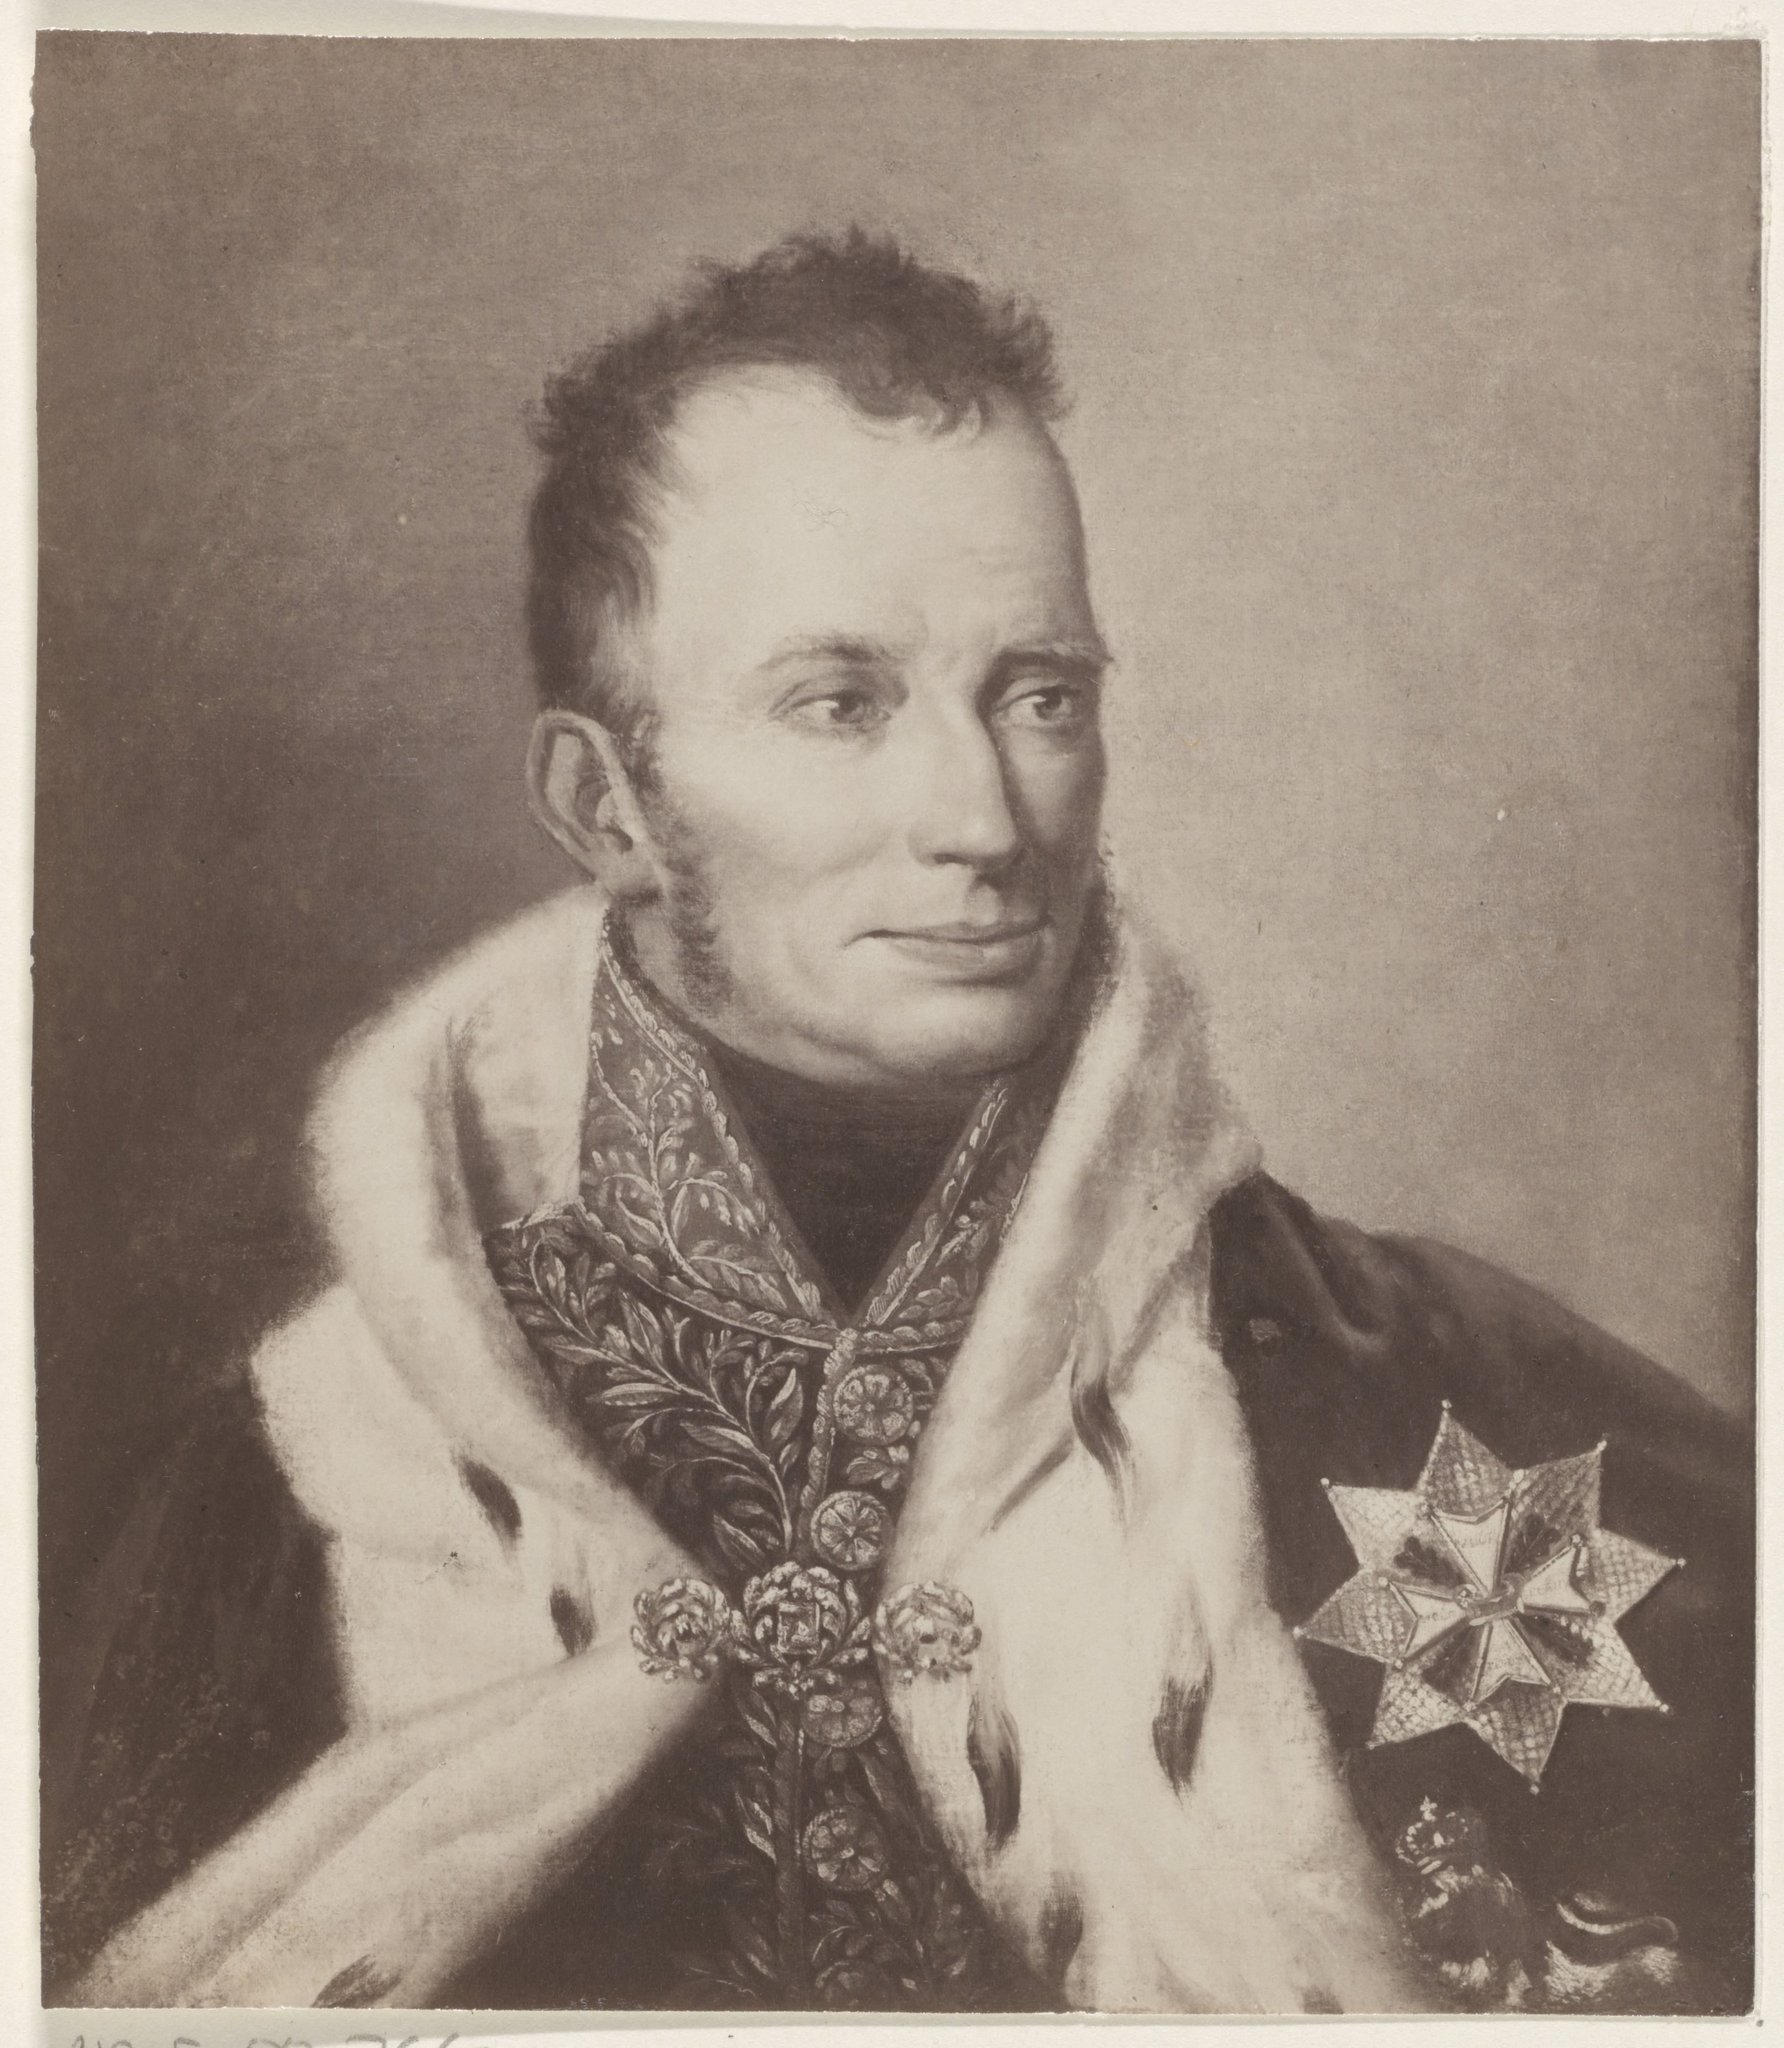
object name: photograph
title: Portret van Willem I Frederik, koning der Nederlanden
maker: Anonymous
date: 1850-1930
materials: photographic support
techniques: photography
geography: netherlands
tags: the hague, berlin, william i of the netherlands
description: De hier vermelde titel verwijst naar de hoogst verkregen titel van de geportretteerde, niet per se naar de titel die de geportretteerde op deze voorstelling draagt.